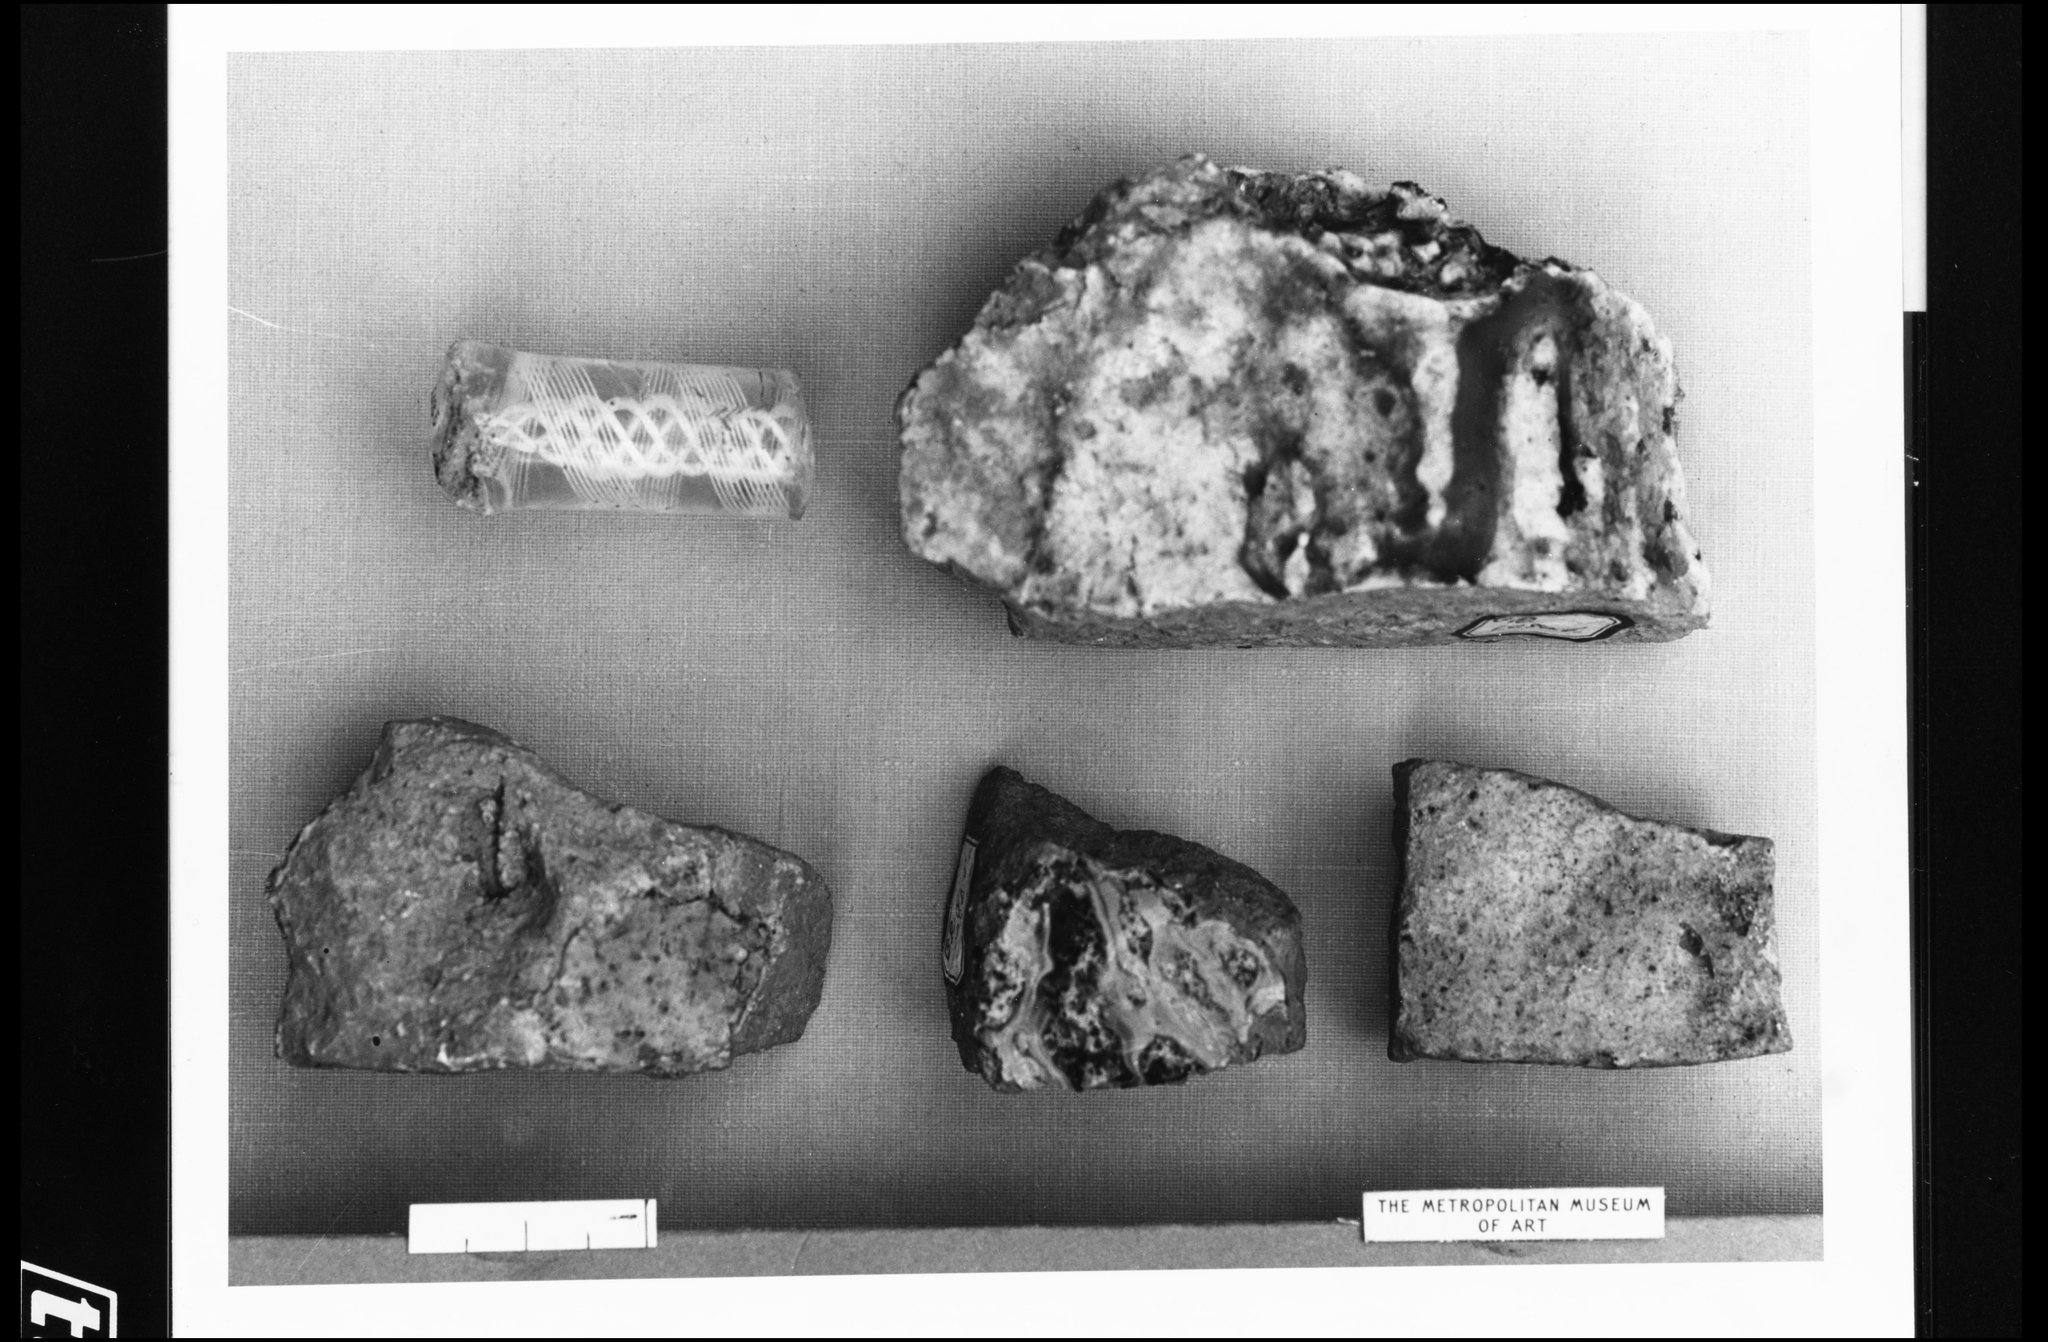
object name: fragment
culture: american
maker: stiegel's manheim factory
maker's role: maker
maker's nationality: american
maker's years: 1763-1774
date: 1763-1774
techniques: glassblowing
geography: united states